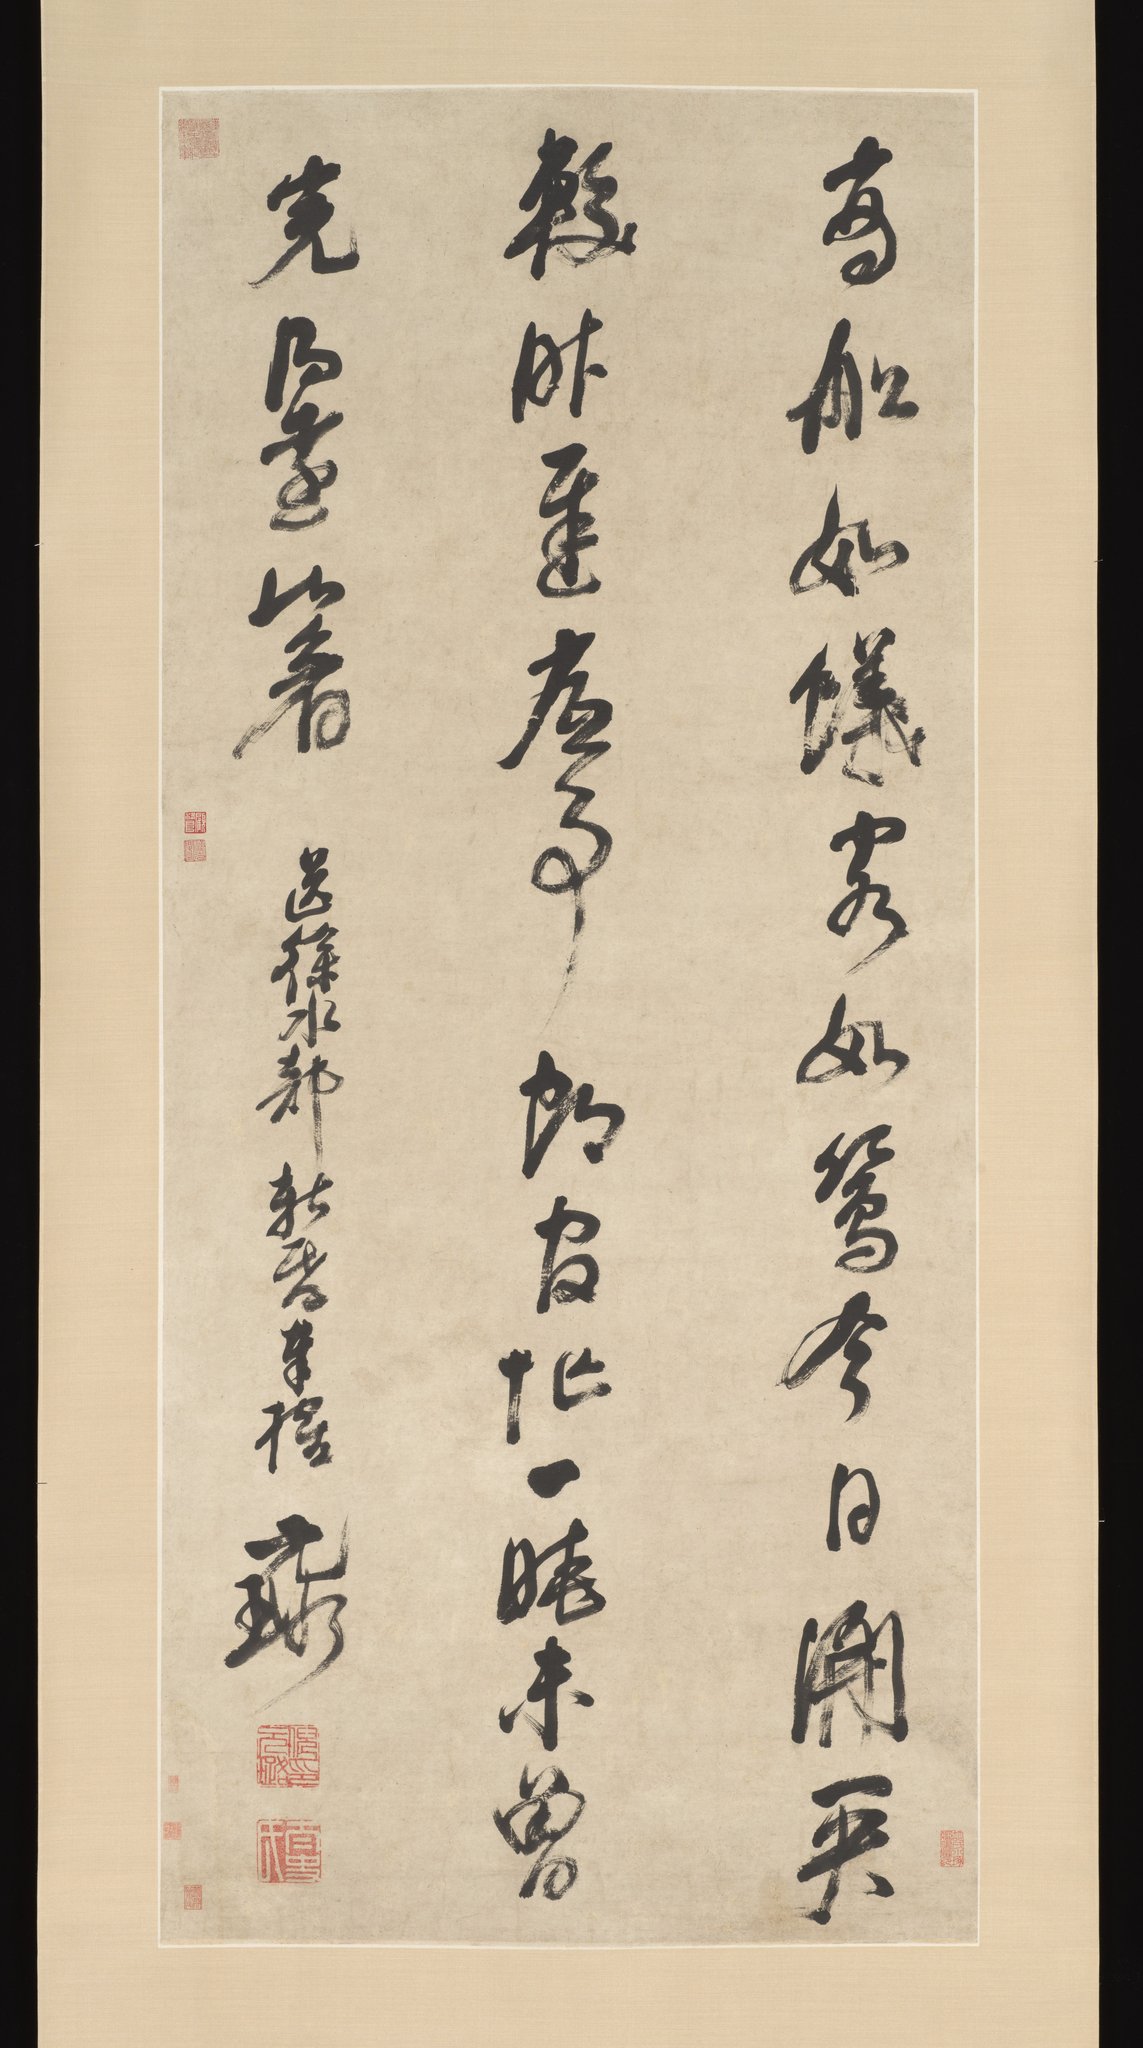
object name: hanging scroll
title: Calligraphy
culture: chinese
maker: ni yuanlu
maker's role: artist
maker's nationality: chinese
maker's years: 1593-1644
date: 1593-1644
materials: ink, paper